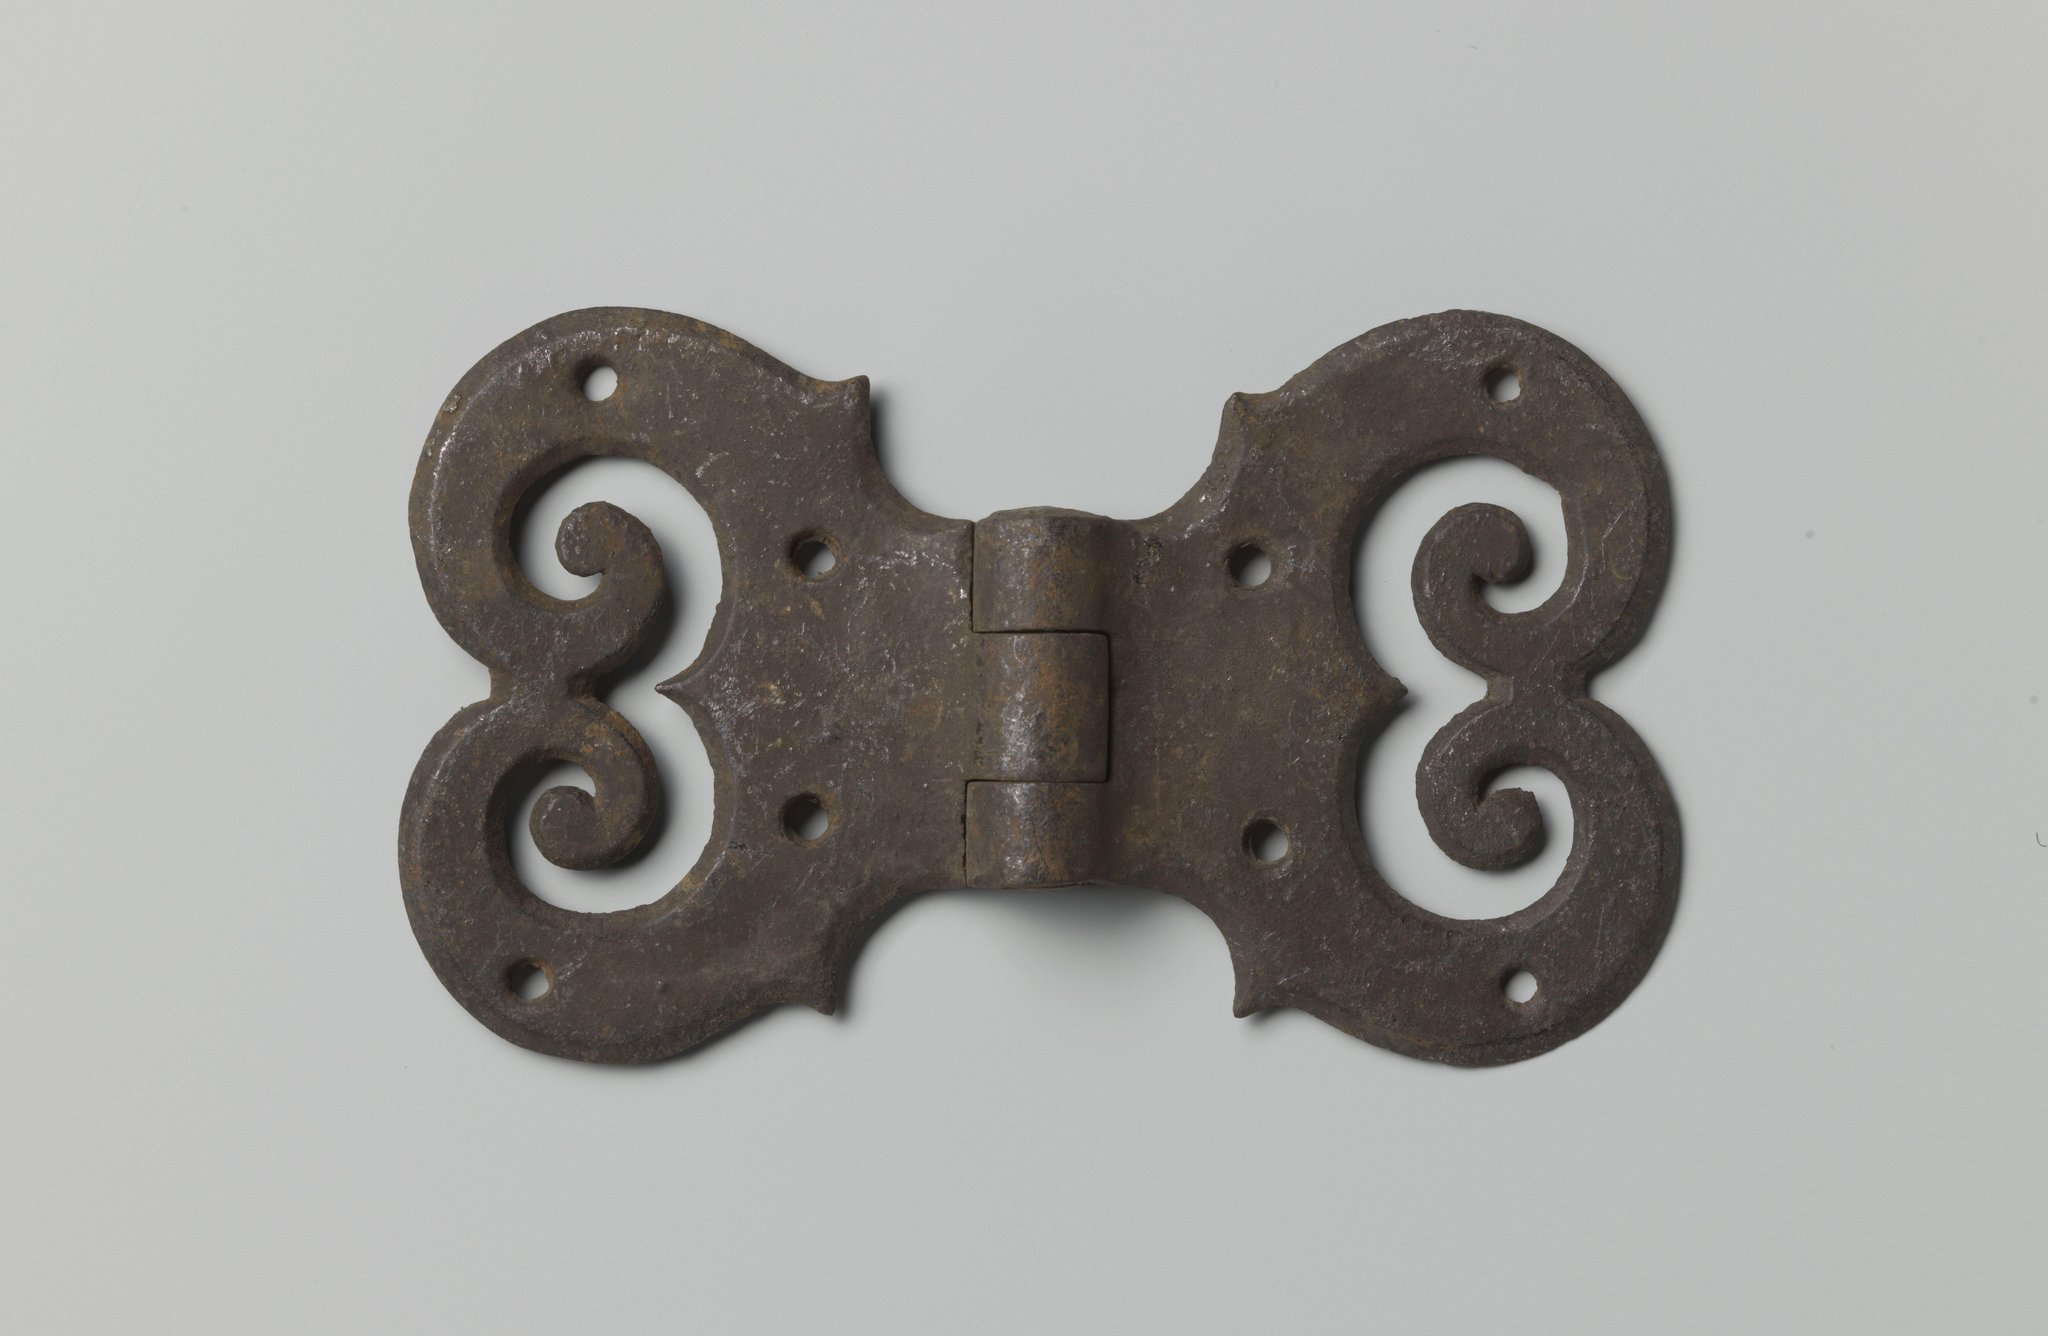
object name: scharnier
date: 1400-1950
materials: iron